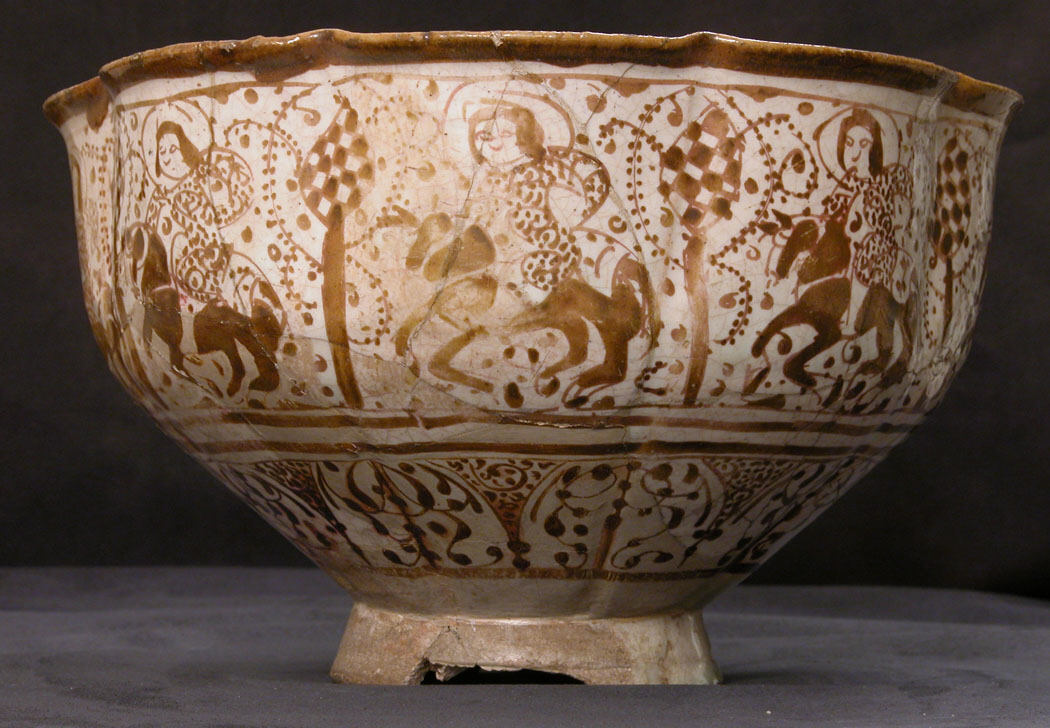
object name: bowl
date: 1101-1300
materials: stonepaste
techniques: luster painting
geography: iran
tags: men,horses